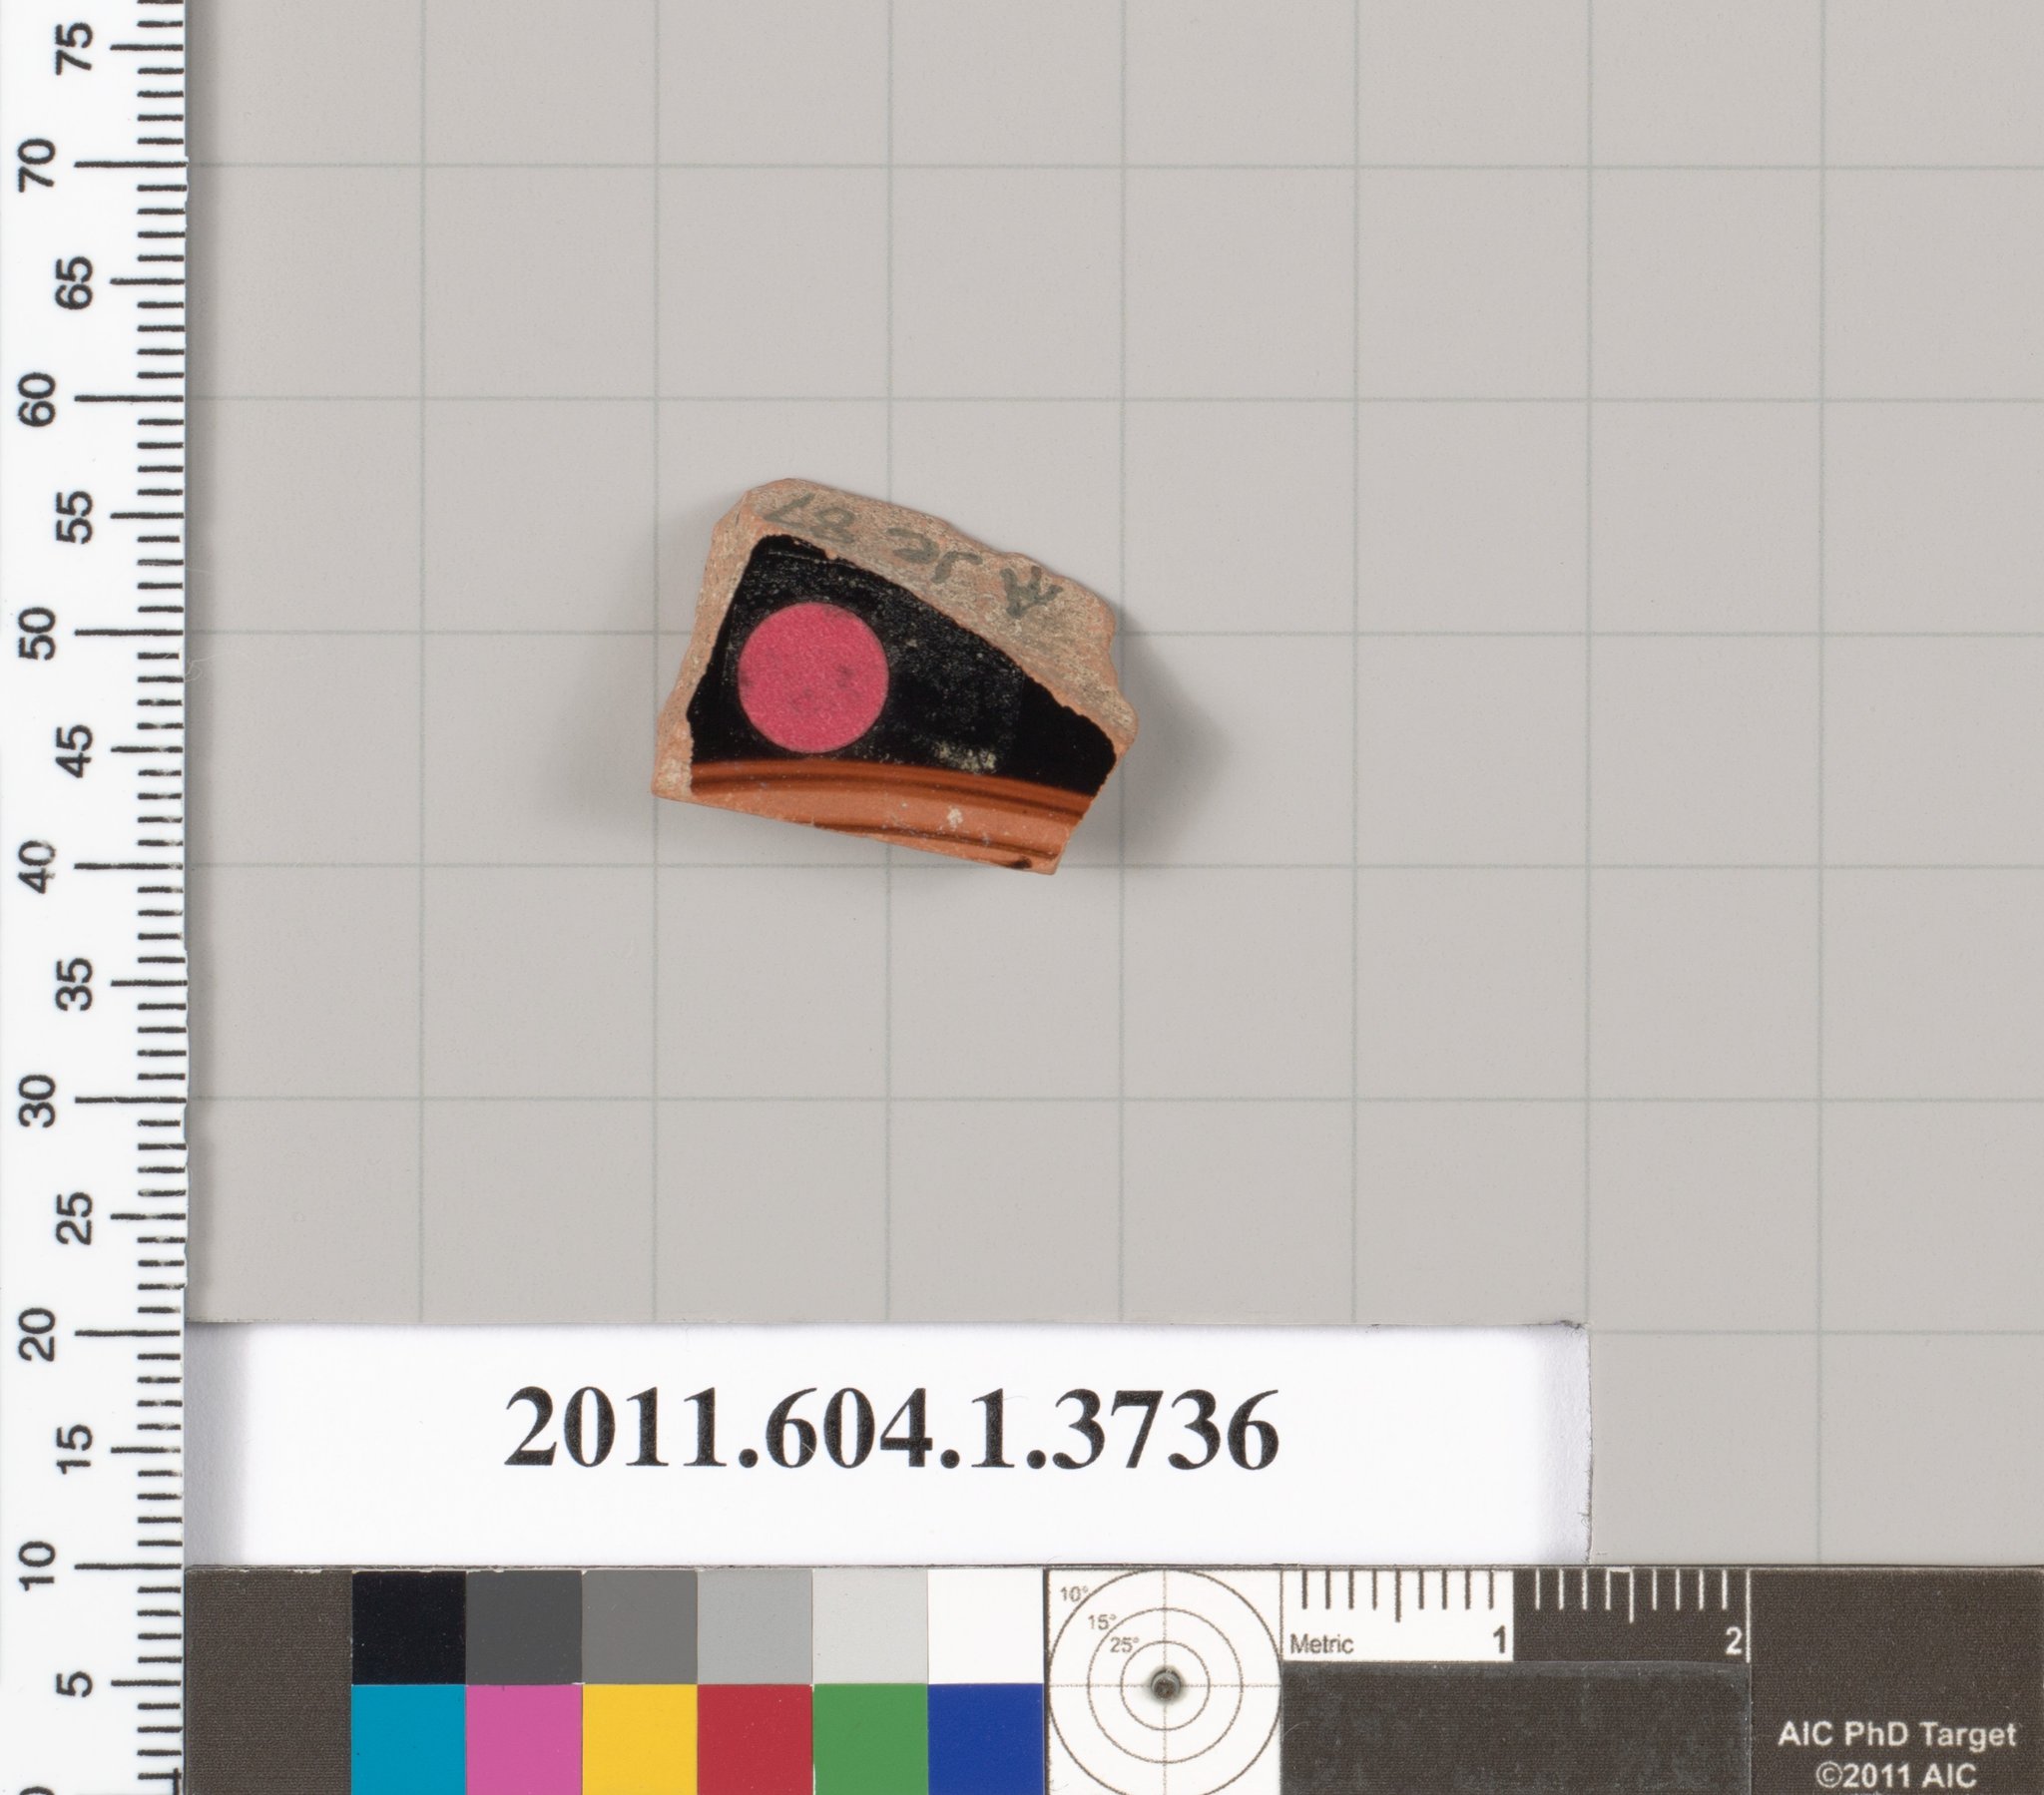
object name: kylix fragment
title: Terracotta fragment of a kylix (drinking cup)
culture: greek, attic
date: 490-470 BCE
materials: terracotta